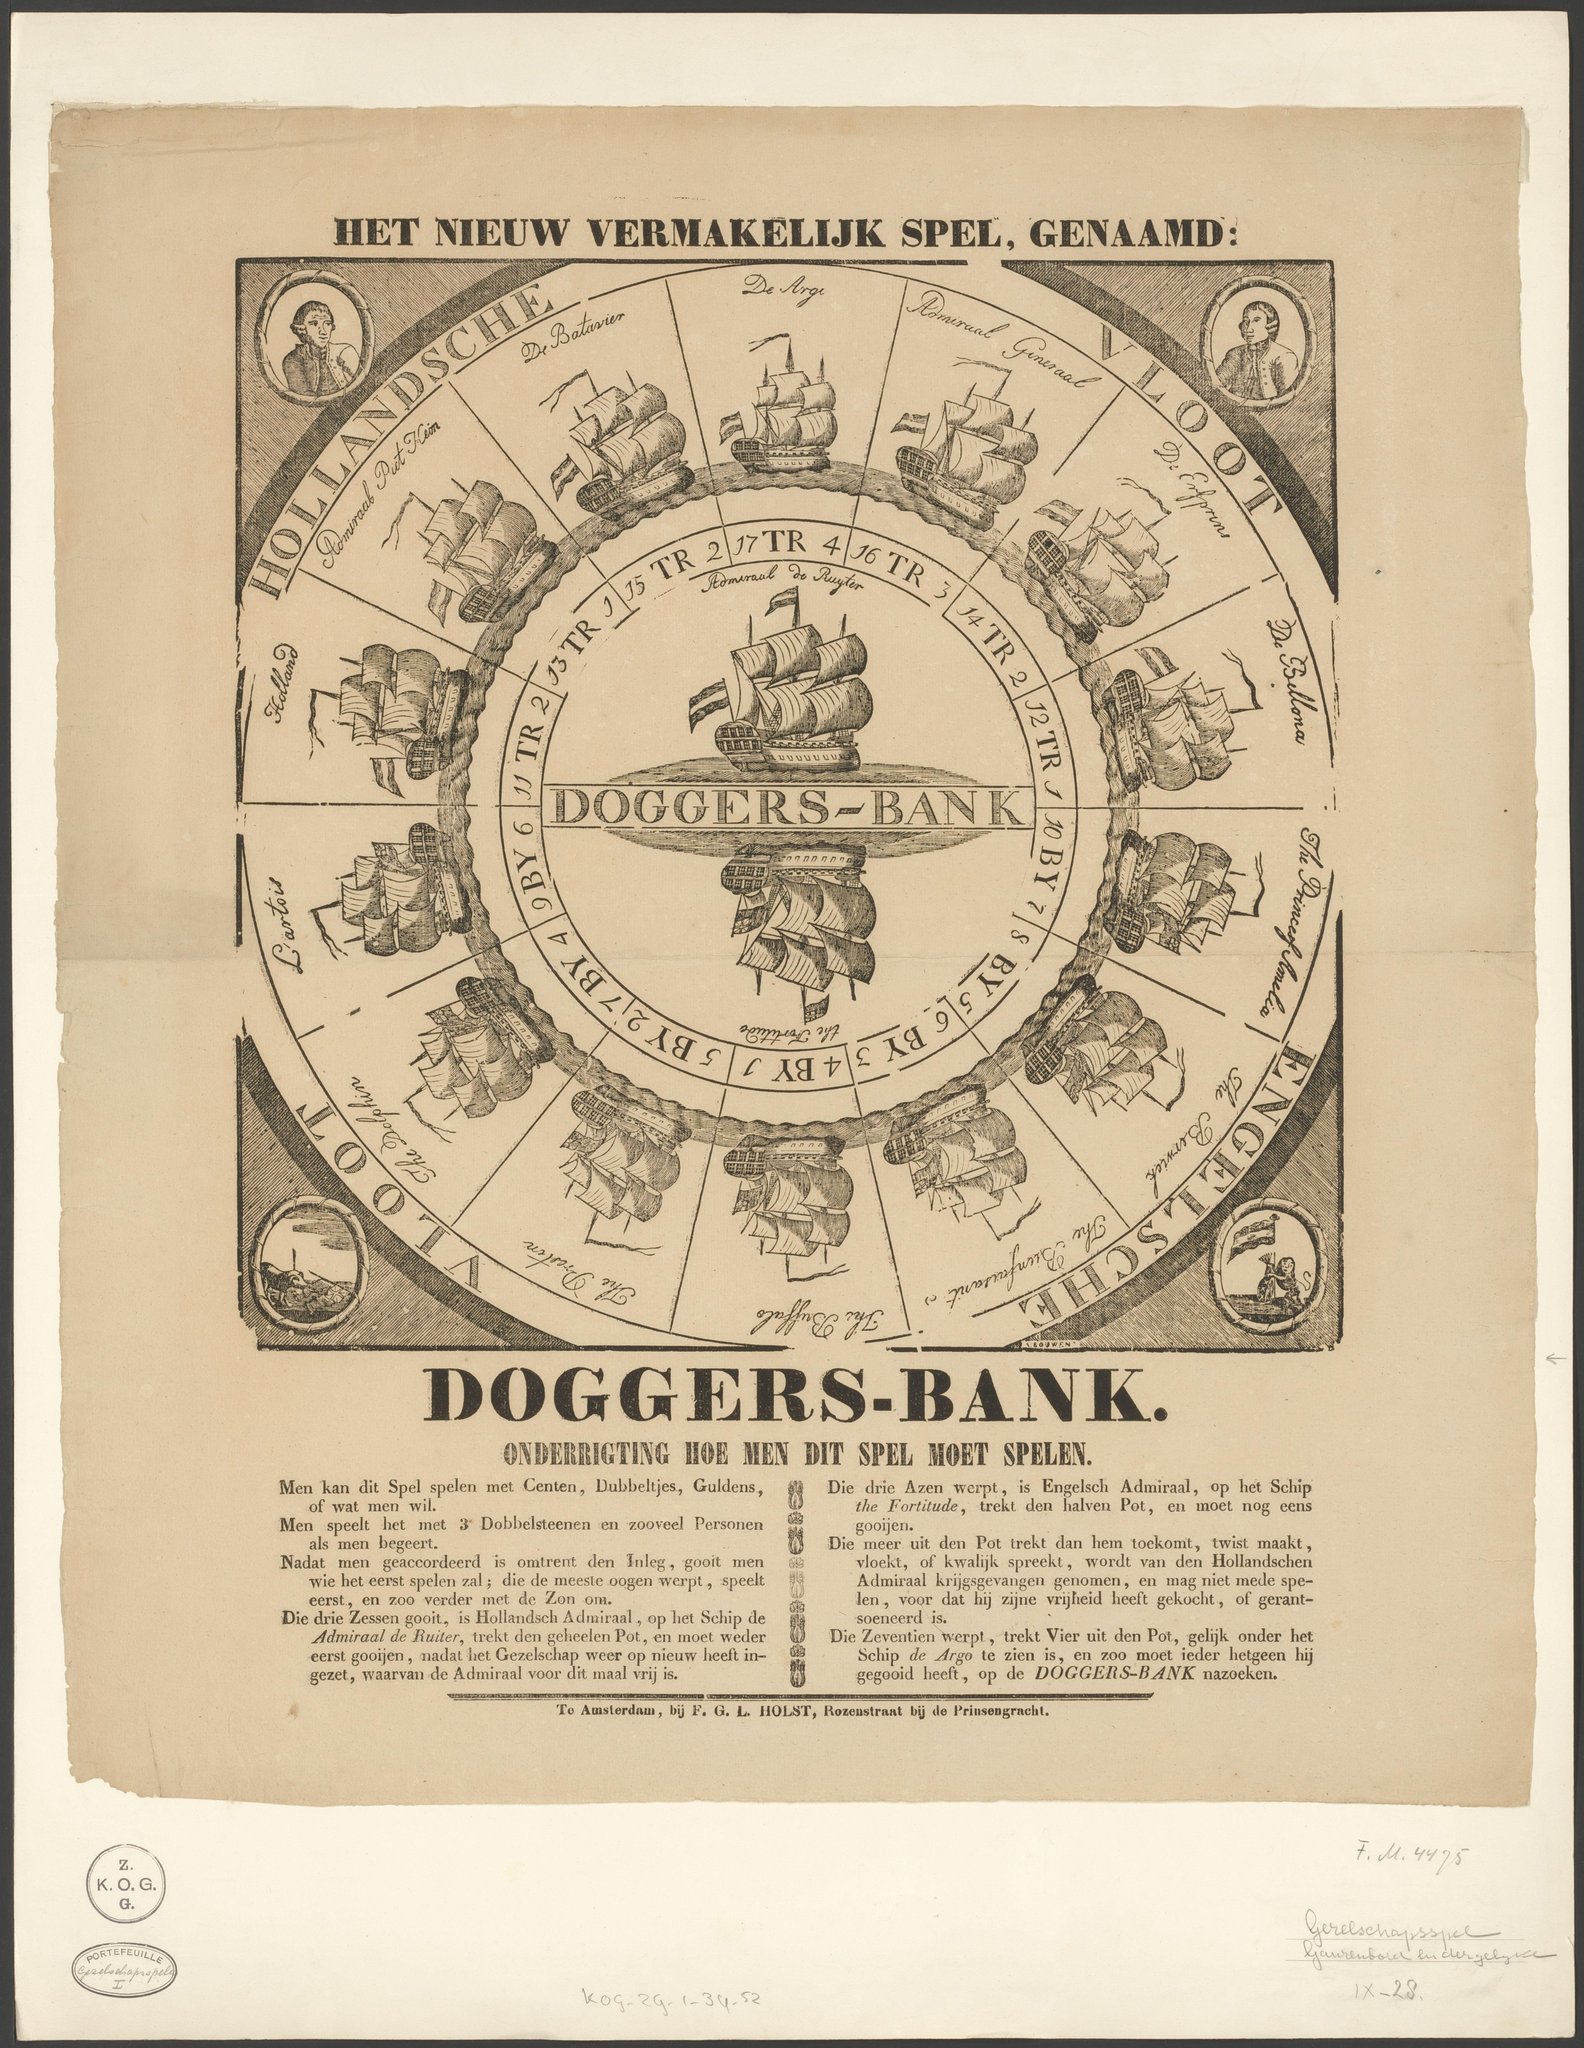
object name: print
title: Het nieuw vermakelijk spel, genaamd Doggersbank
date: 1841-1864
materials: paper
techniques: letterpress printing, engraving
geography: netherlands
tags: sailing-ship, sailing-boat, board-games of chance, battle (+ sailing-ships)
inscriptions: collector's mark: Lugt 1641, collector's mark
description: In een cirkel met veertien vakken zijn in de bovenste helft zeven Hollandse schepen afgebeeld en in de onderste helft zeven Engelse schepen. Boven elk schip staat de naam van het schip en eronder wat de speler betaalt of ontvangt als hij op het vak komt. In het midden van de cirkel het Hollandse vlaggenschip "Admiraal de Ruyter" en het Engelse vlaggenschip "the Fortitude". Onder het spel in twee kolommen de spelregels. Onderwerpsrubrieken binnen de Atlas Zeden en Gewoonten: Spel en Vermaak; gezelschapsspel, ganzenbord en dergelijke.